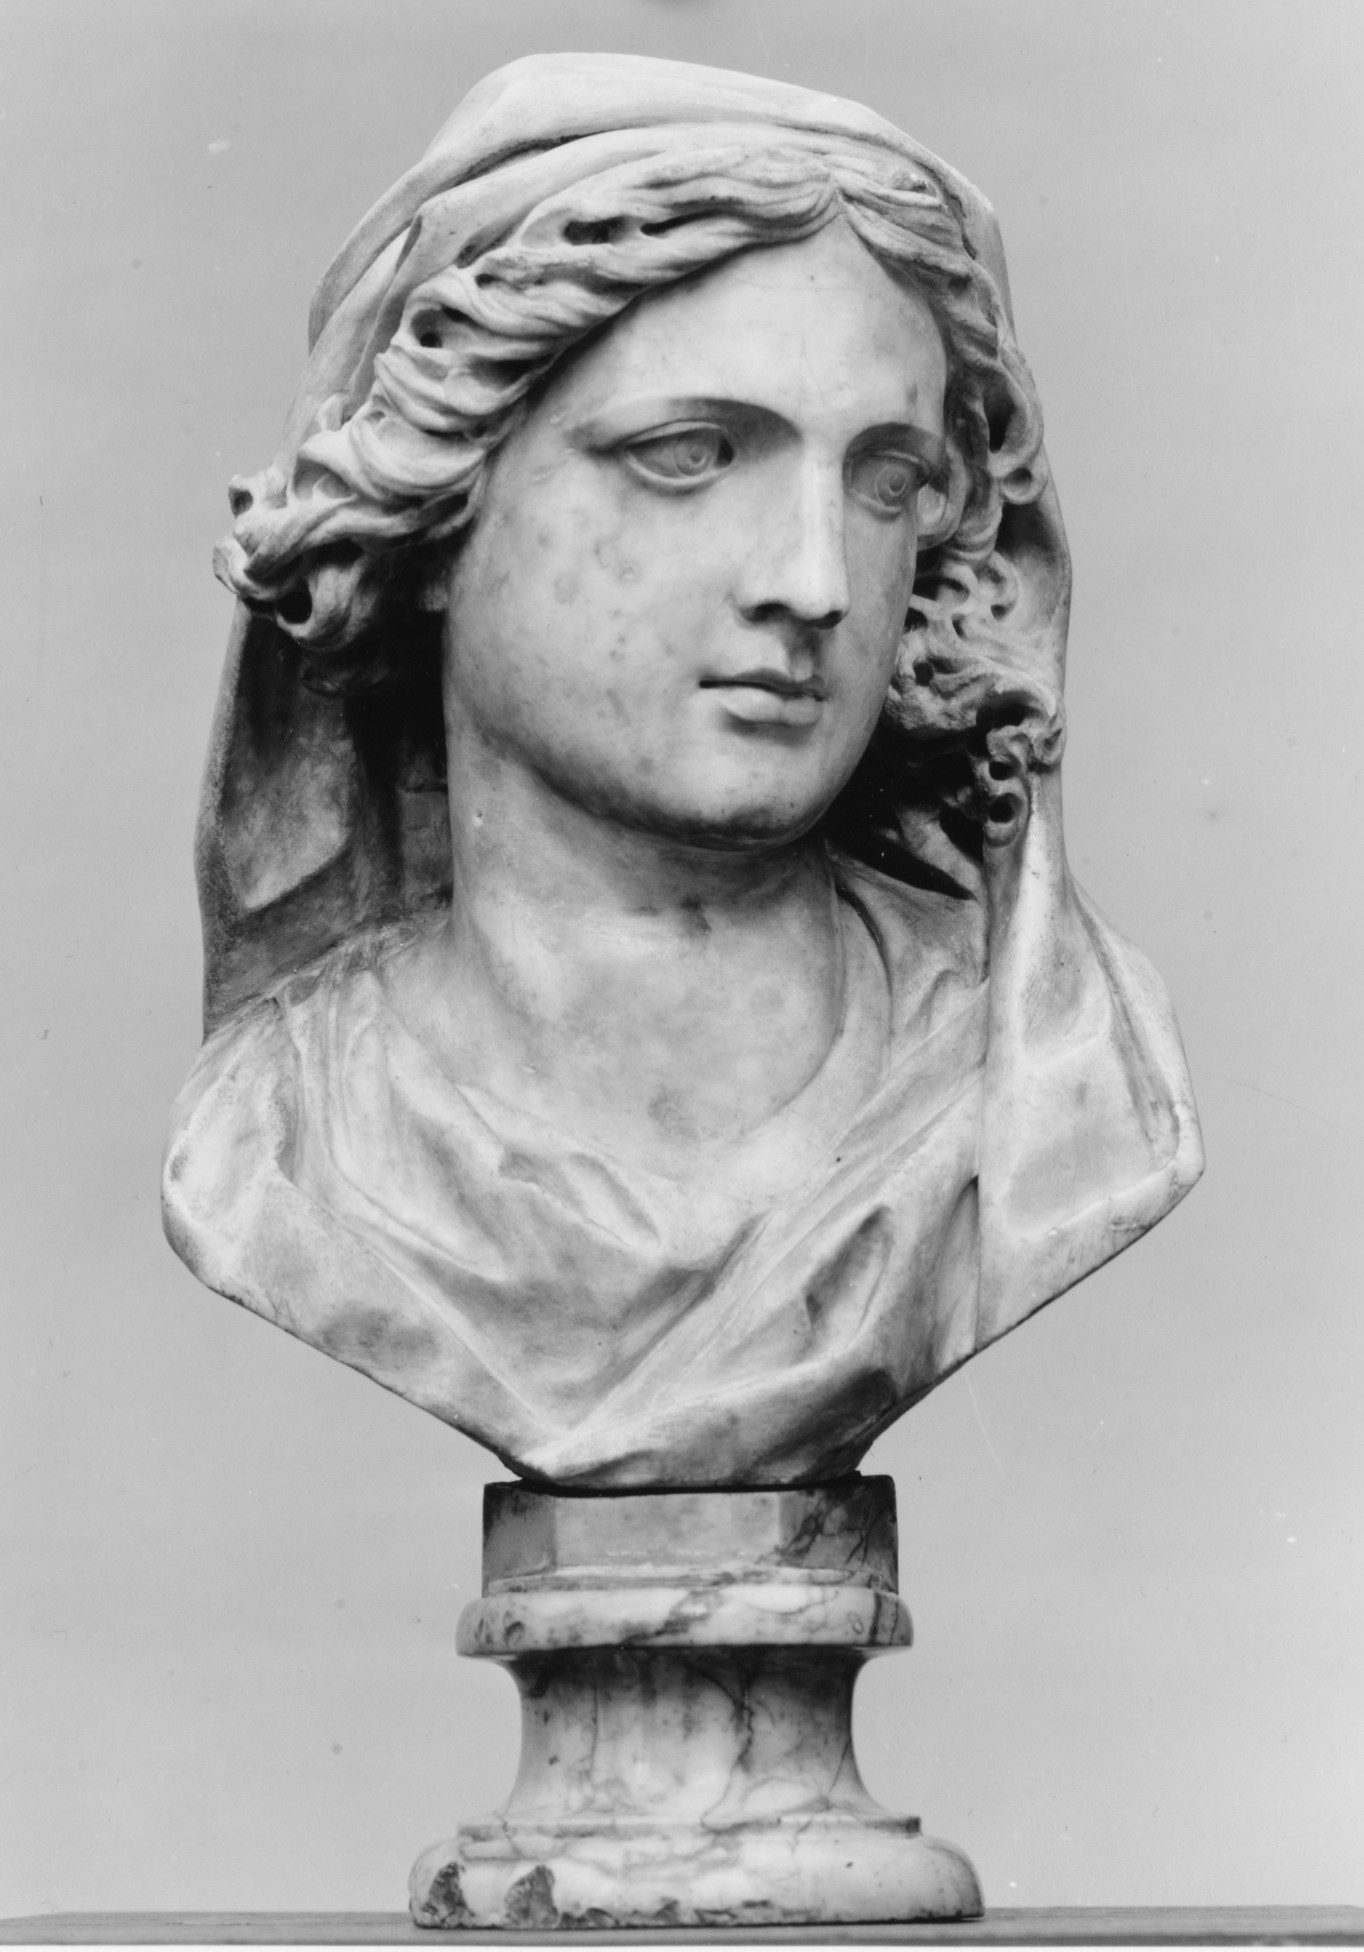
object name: bust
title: Head of the Virgin Annunciate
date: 1634-1666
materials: marble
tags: heads,women